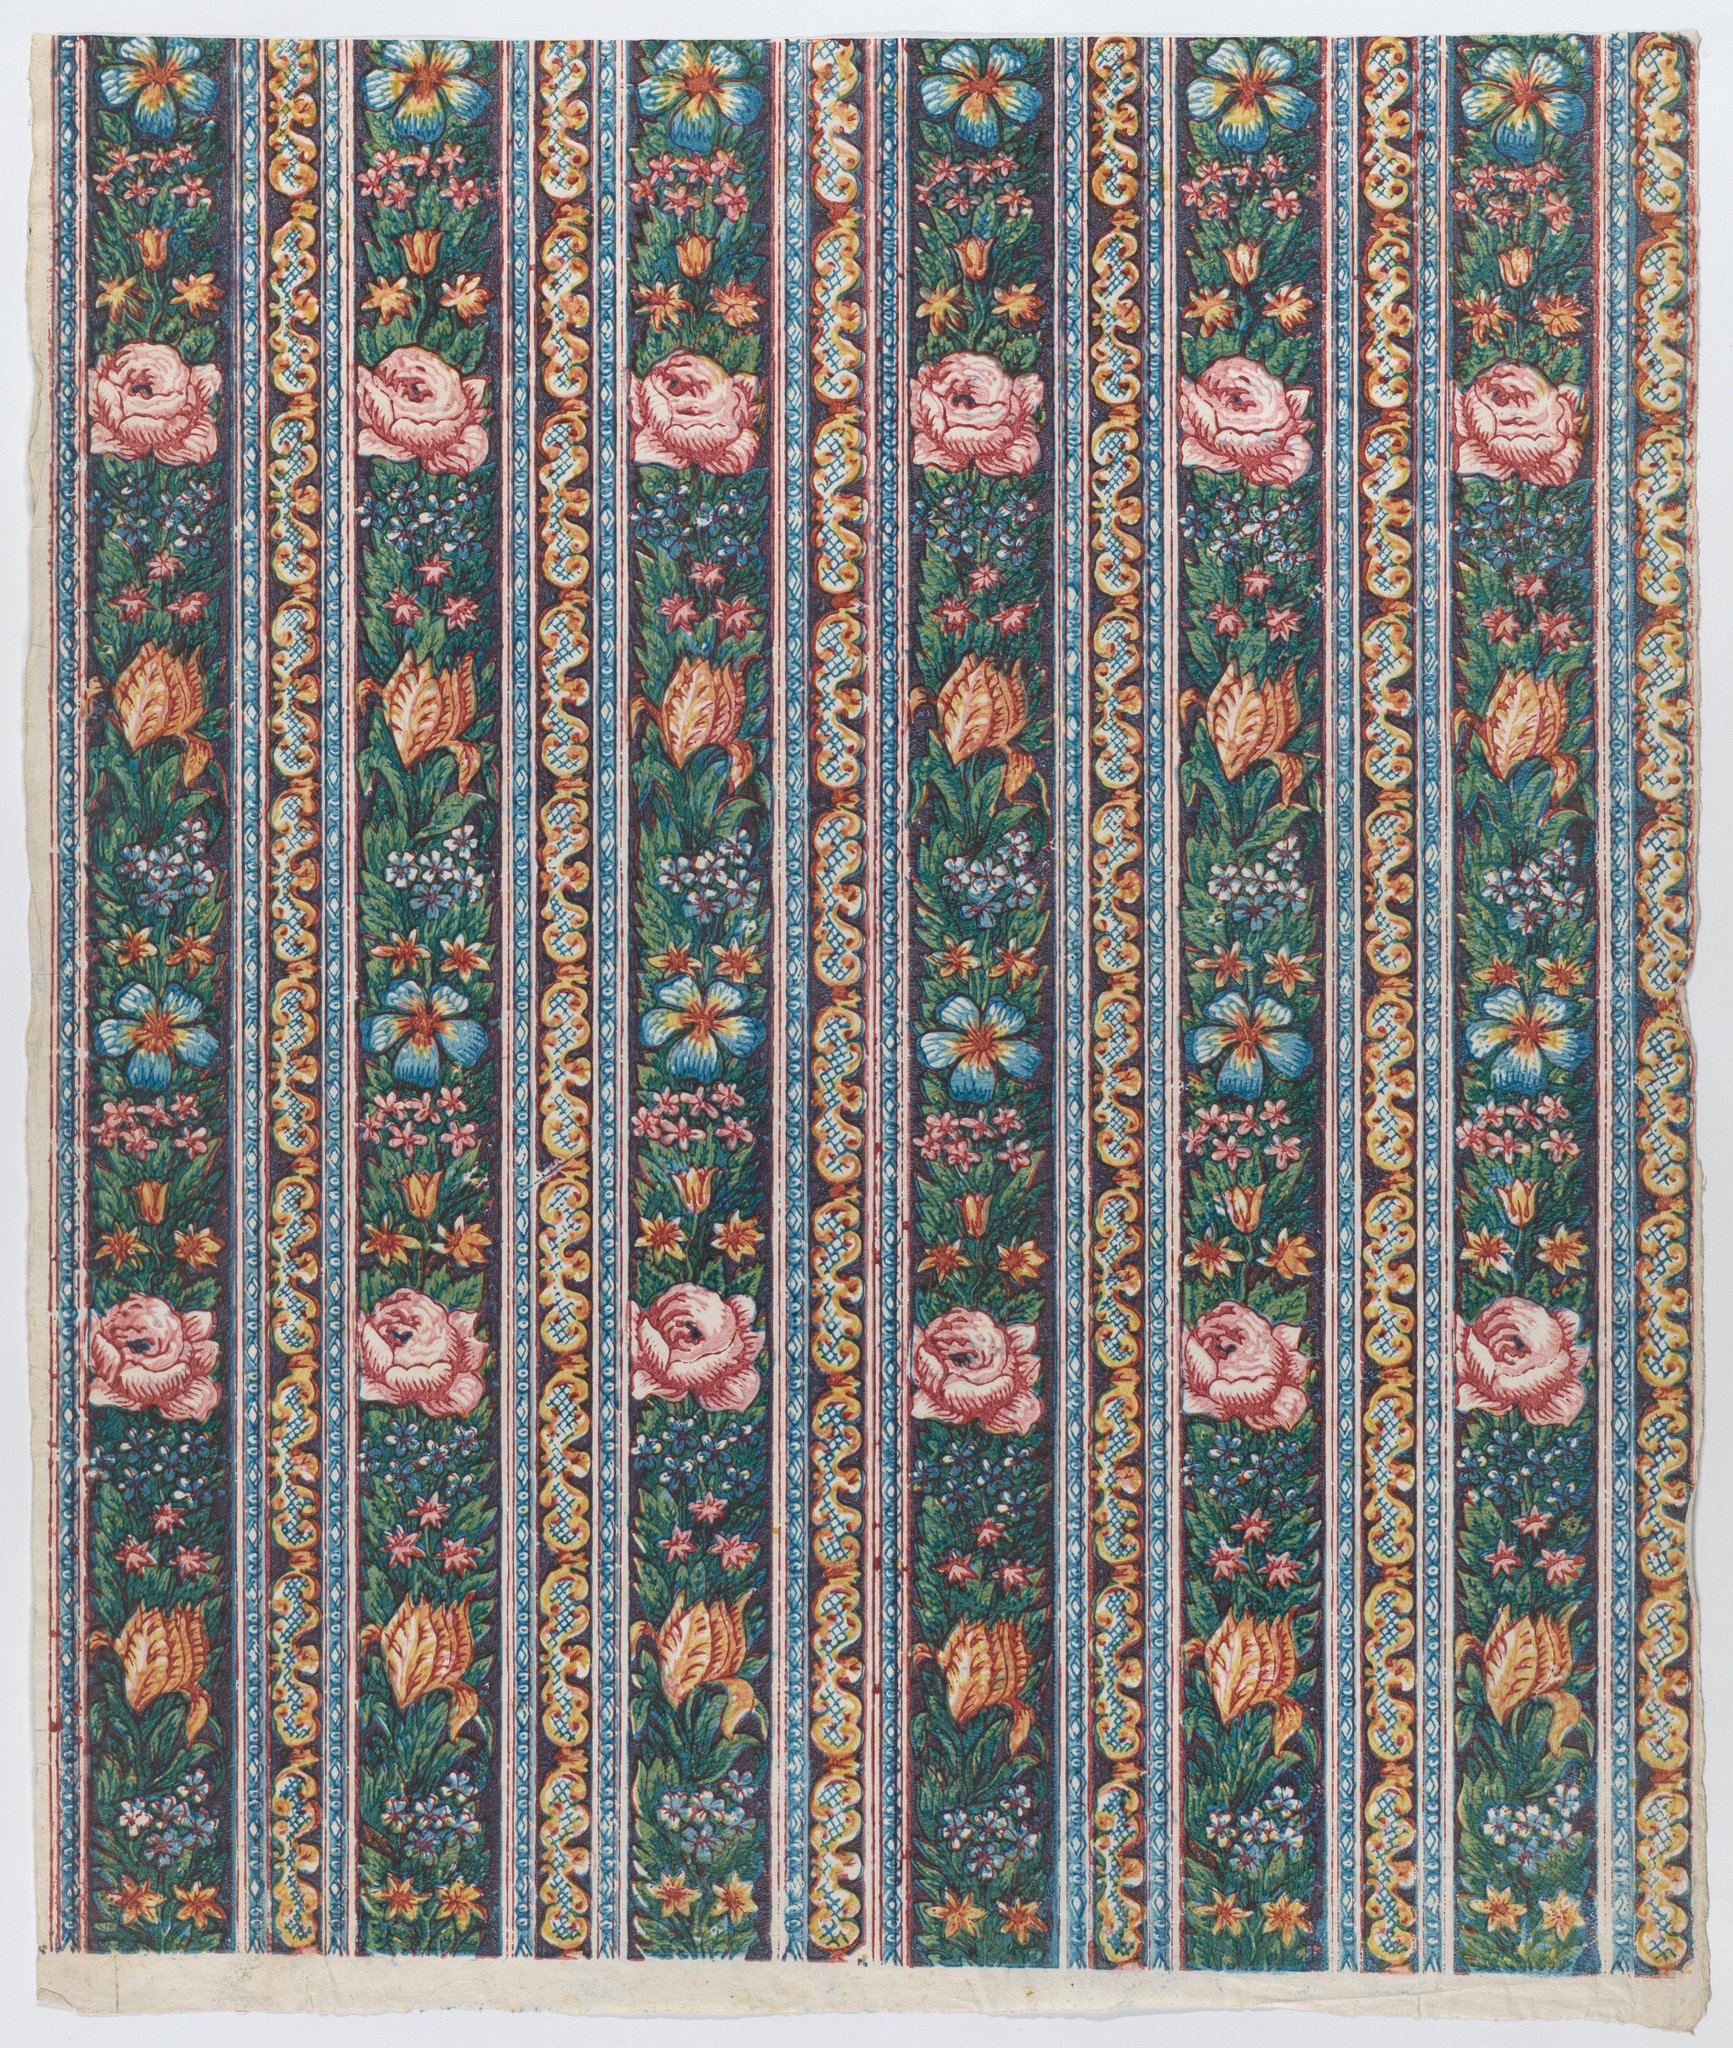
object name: print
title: Sheet with a six borders with floral garlands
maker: Anonymous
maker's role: artist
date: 1767-1866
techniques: relief print